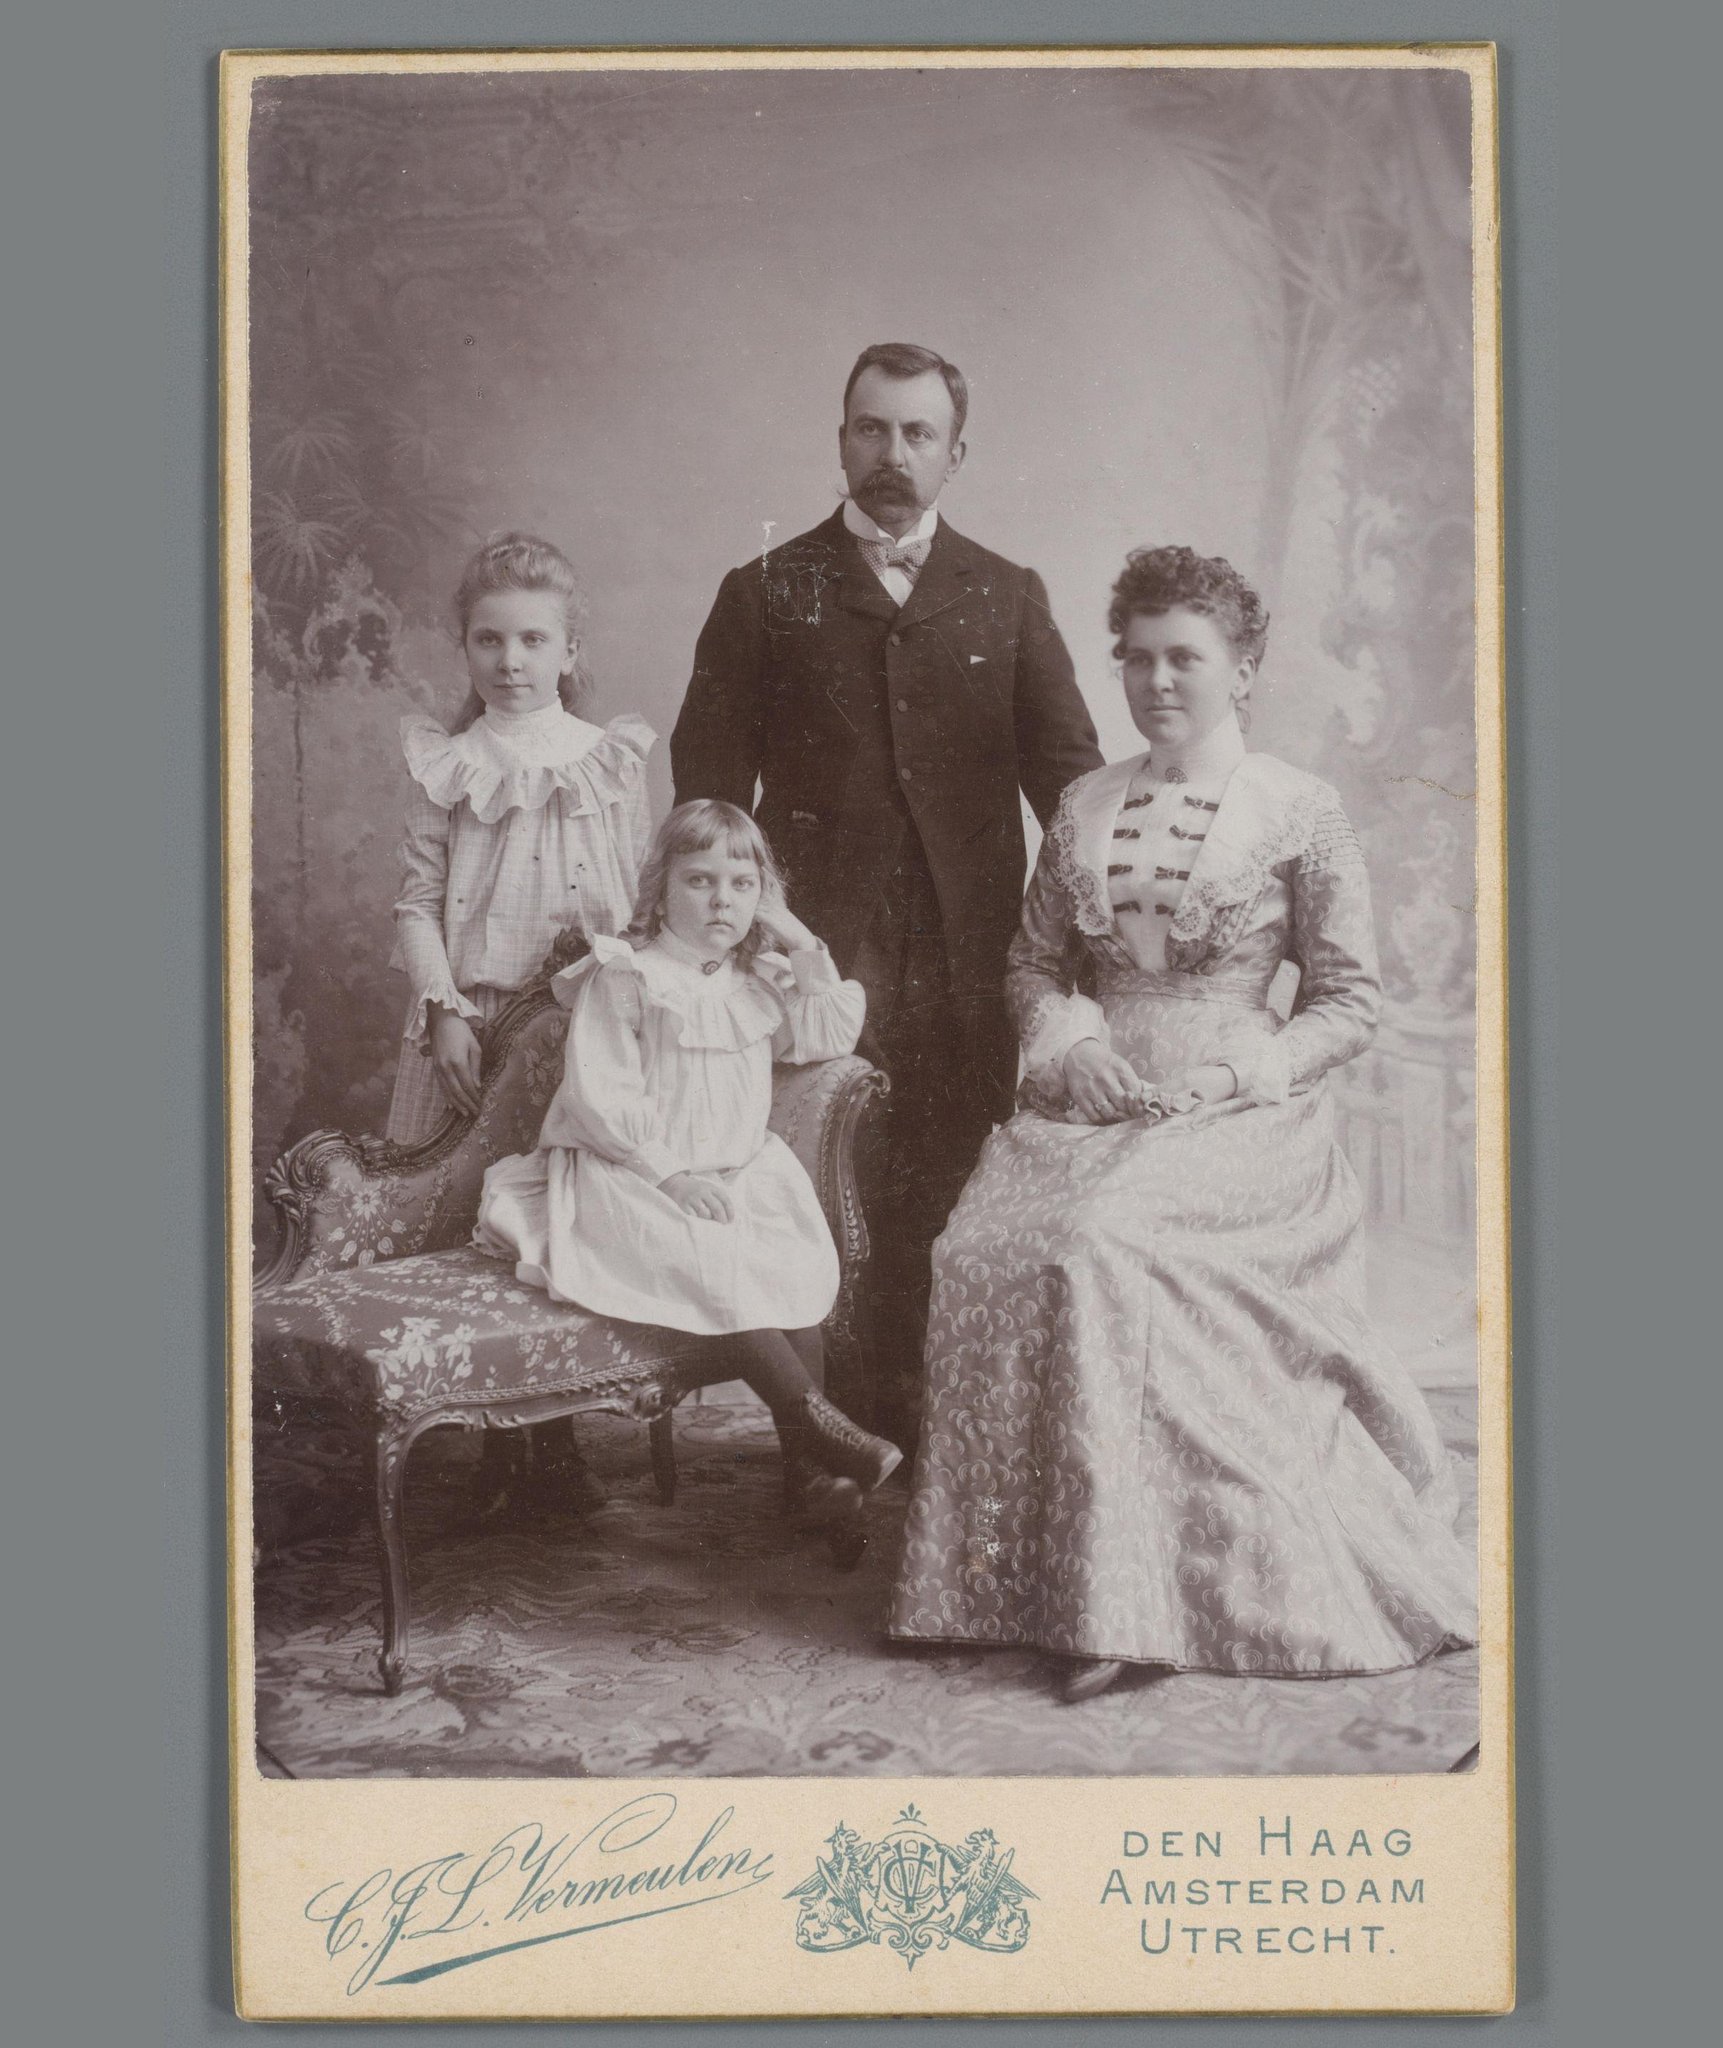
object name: cabinet photograph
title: Groepsportret van W.H. Lohman met zijn gezin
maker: cornelis johannes lodewicus vermeulen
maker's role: fotograaf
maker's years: 1861-1936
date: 1901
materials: paper, cardboard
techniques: collodion silver print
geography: amsterdam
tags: historical persons, anonymous historical persons portrayed in a group, in a group-portrait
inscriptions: inscription: ‘W.H. Lohman and family,/ by their departure/ for the U:S: of America’, address: ‘den Haag/ Toussaintkade 11./ Intercommunal Telephoon: 774./ Amsterdam/ Heerenstraat 6./ Heiligenweg hoek Singel./ Telephoon No 2340./ Utrecht/ Nieuwe gracht 50./ Telephoon No 750.’